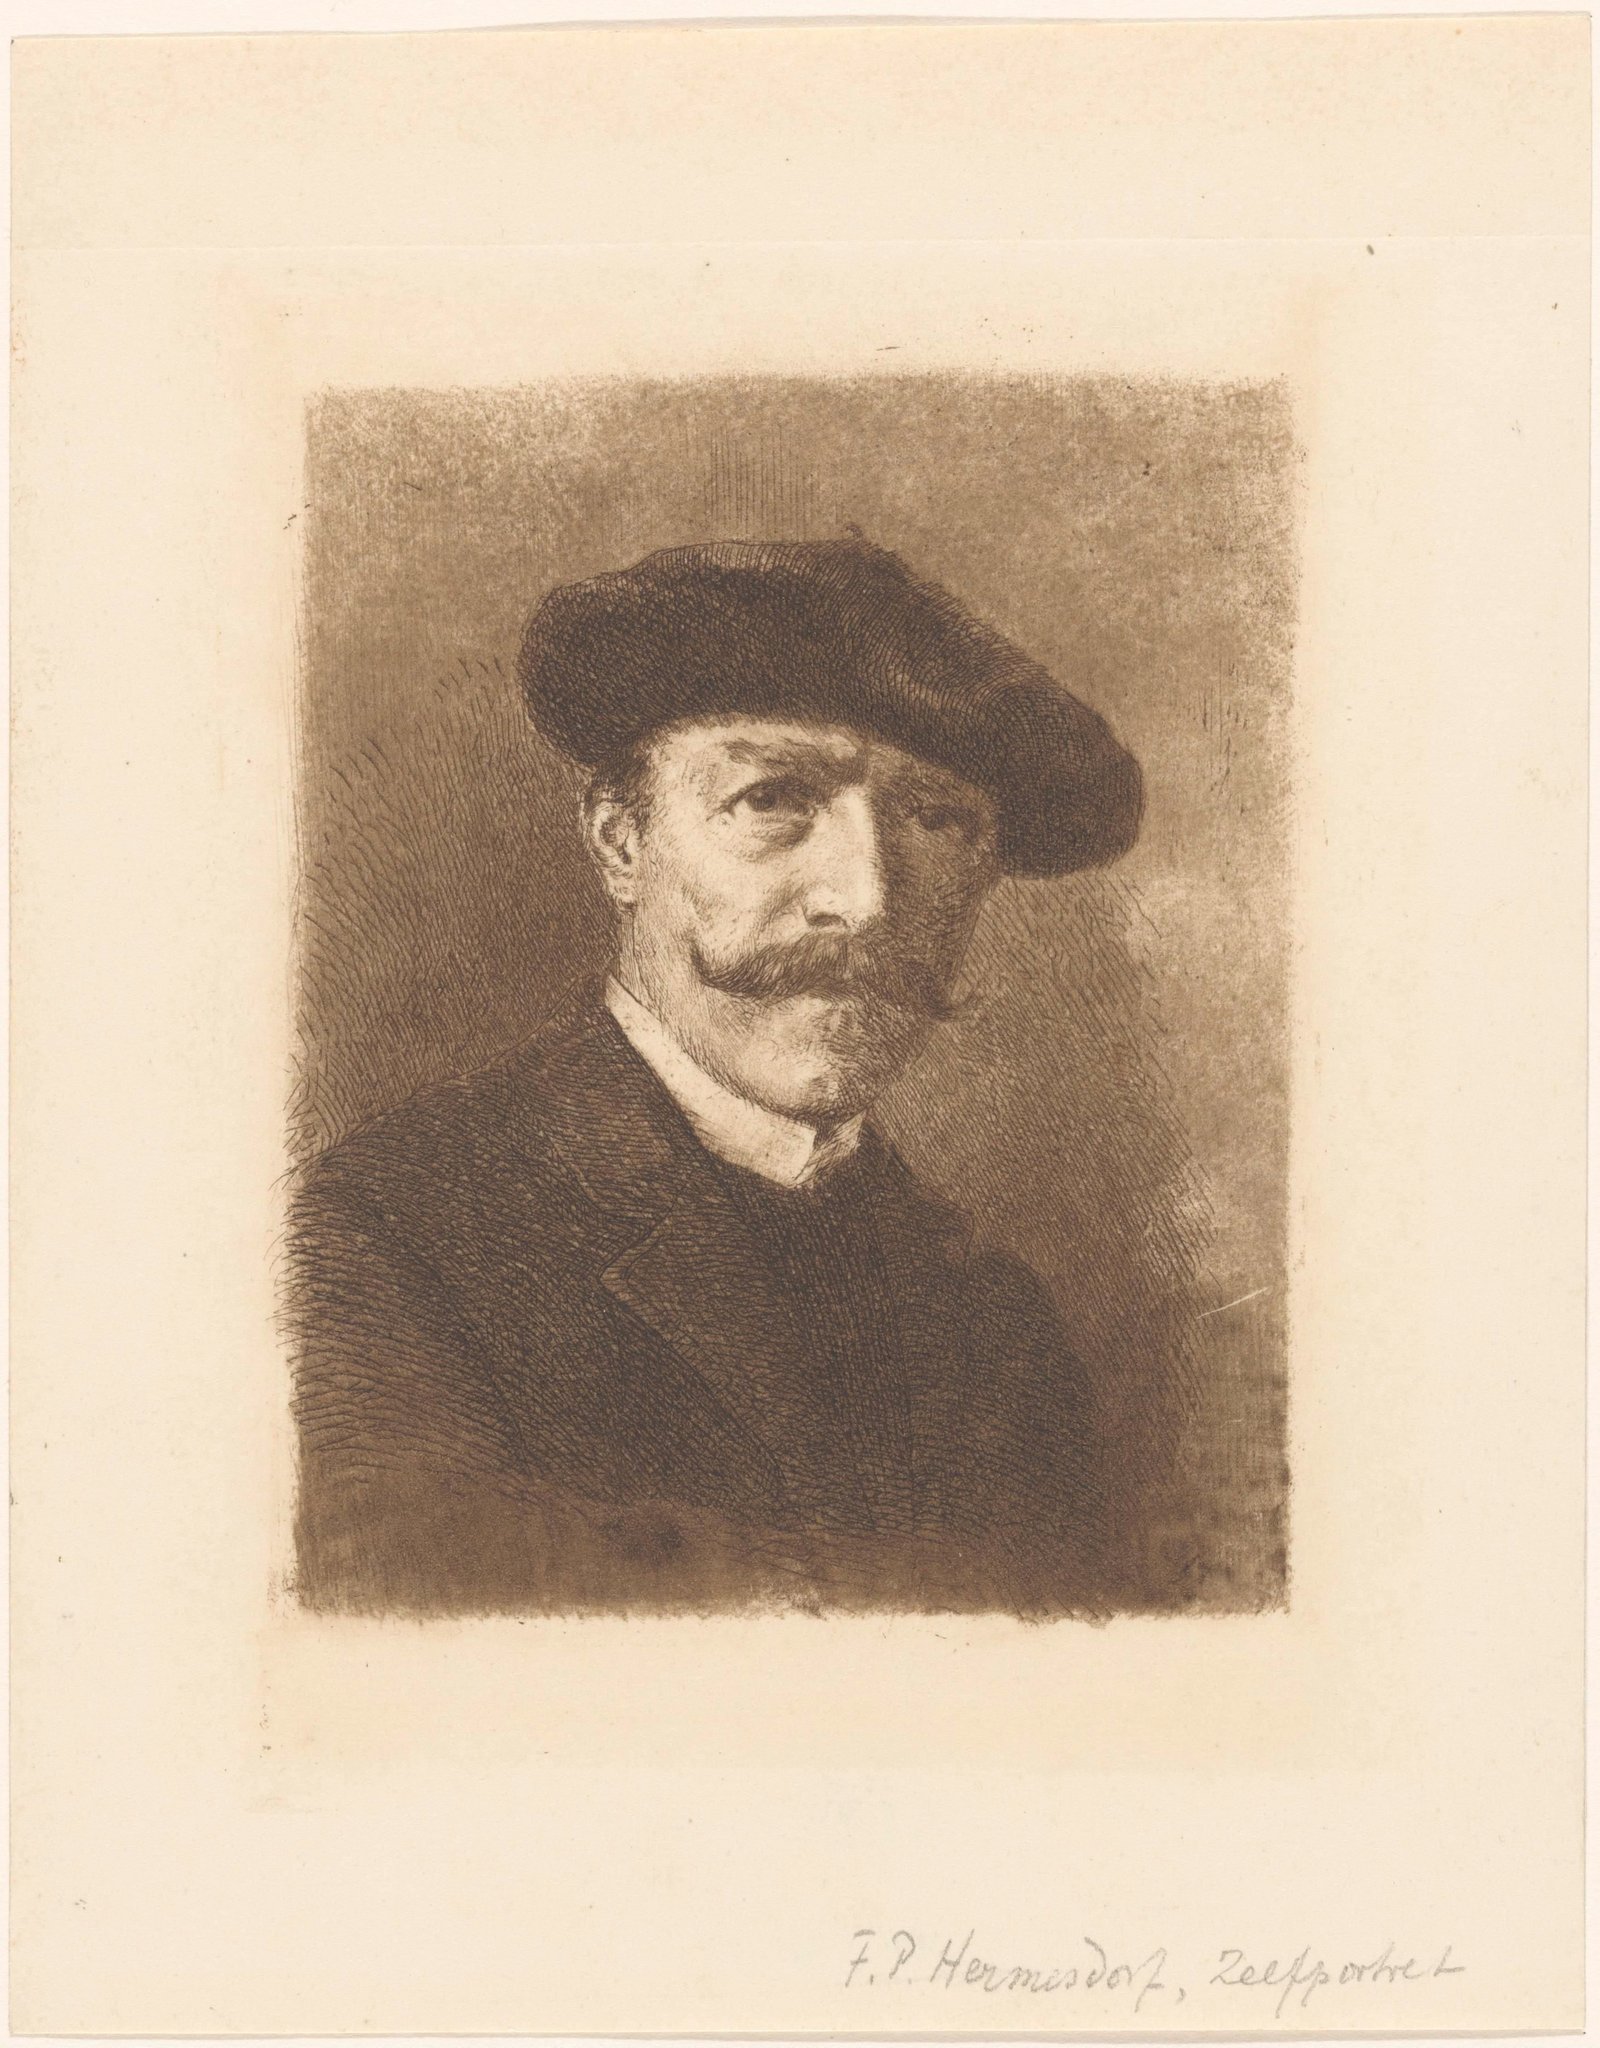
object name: print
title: Zelfportret met baret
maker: frans hermesdorf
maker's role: painter, print maker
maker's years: 1854-1904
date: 1864-1904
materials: paper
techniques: aquatint, etching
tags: painter, frans hermesdorf, portrait, self-portrait of artist, head-gear: beret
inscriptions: collector's mark: Lugt 2228